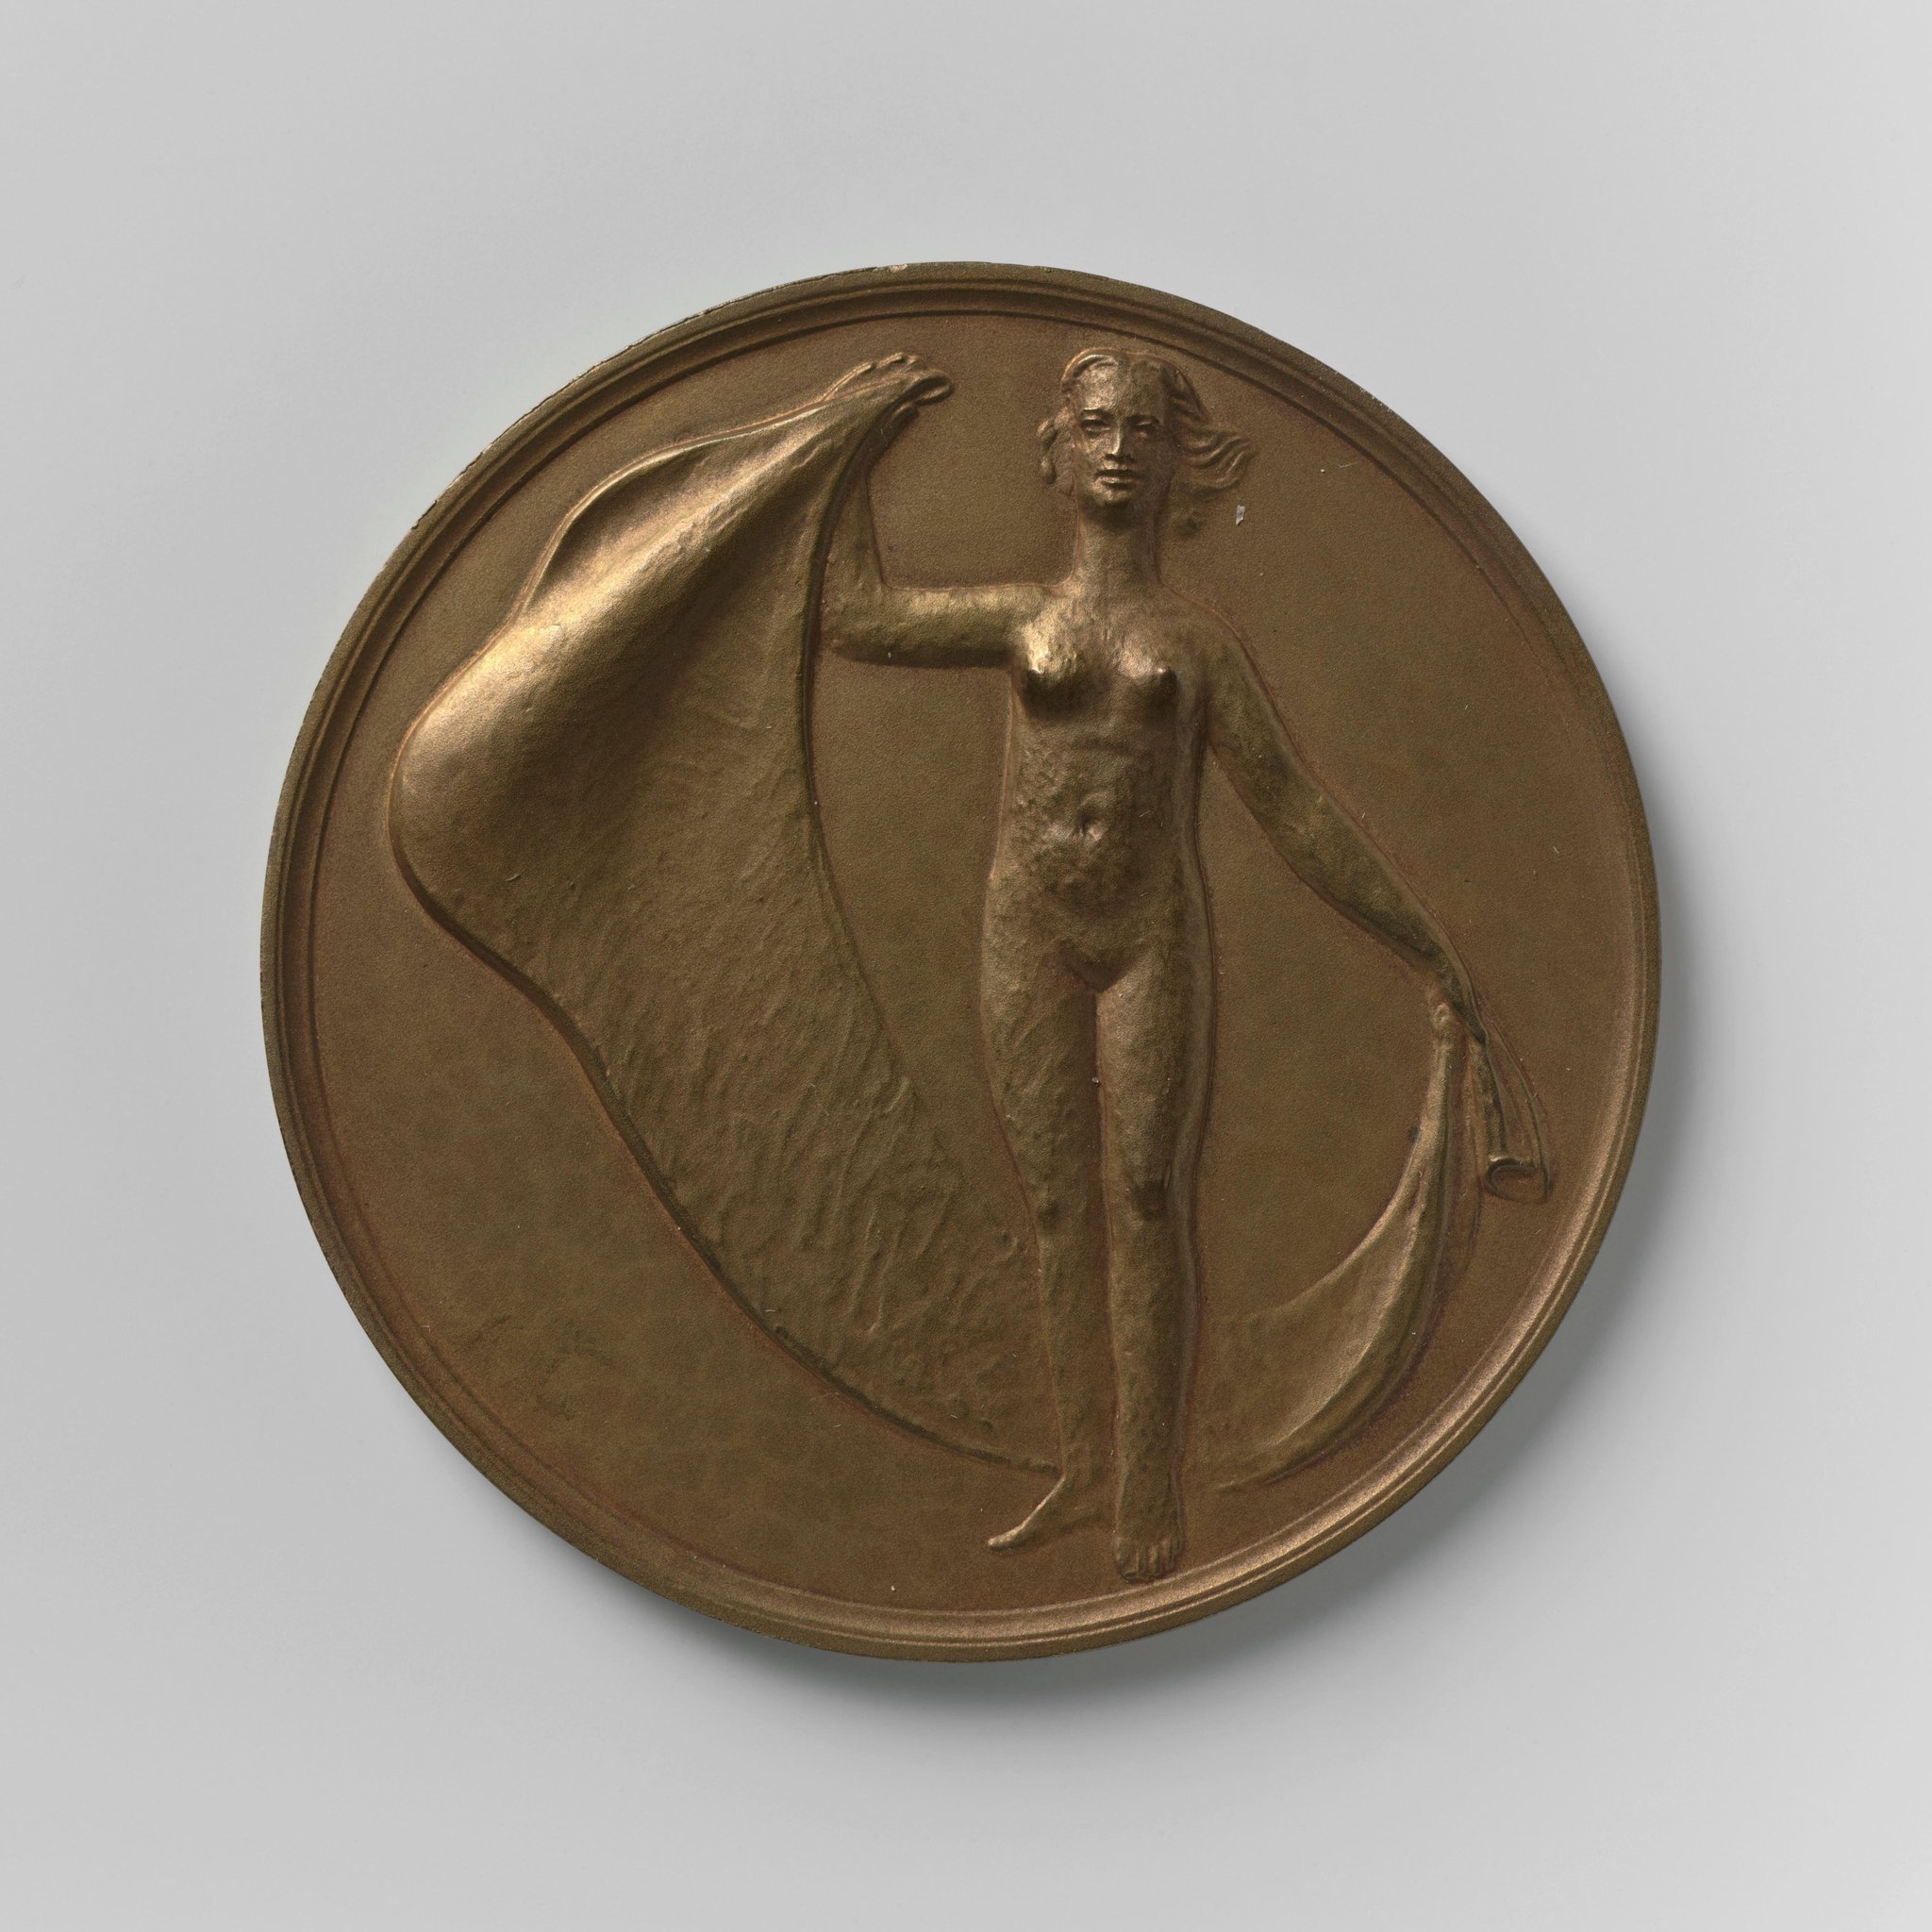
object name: history medal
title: Herkregen Vrijheid (Vereniging voor Penningkunst 1945, jaarpenning)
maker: willem valk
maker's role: sculptor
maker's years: 1898-1977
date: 1945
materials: bronze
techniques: striking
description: Bronzen penning, op de voorzijde een staande vrouw die haar sluier afdoet, op de keerzijde vijf regels tekst.